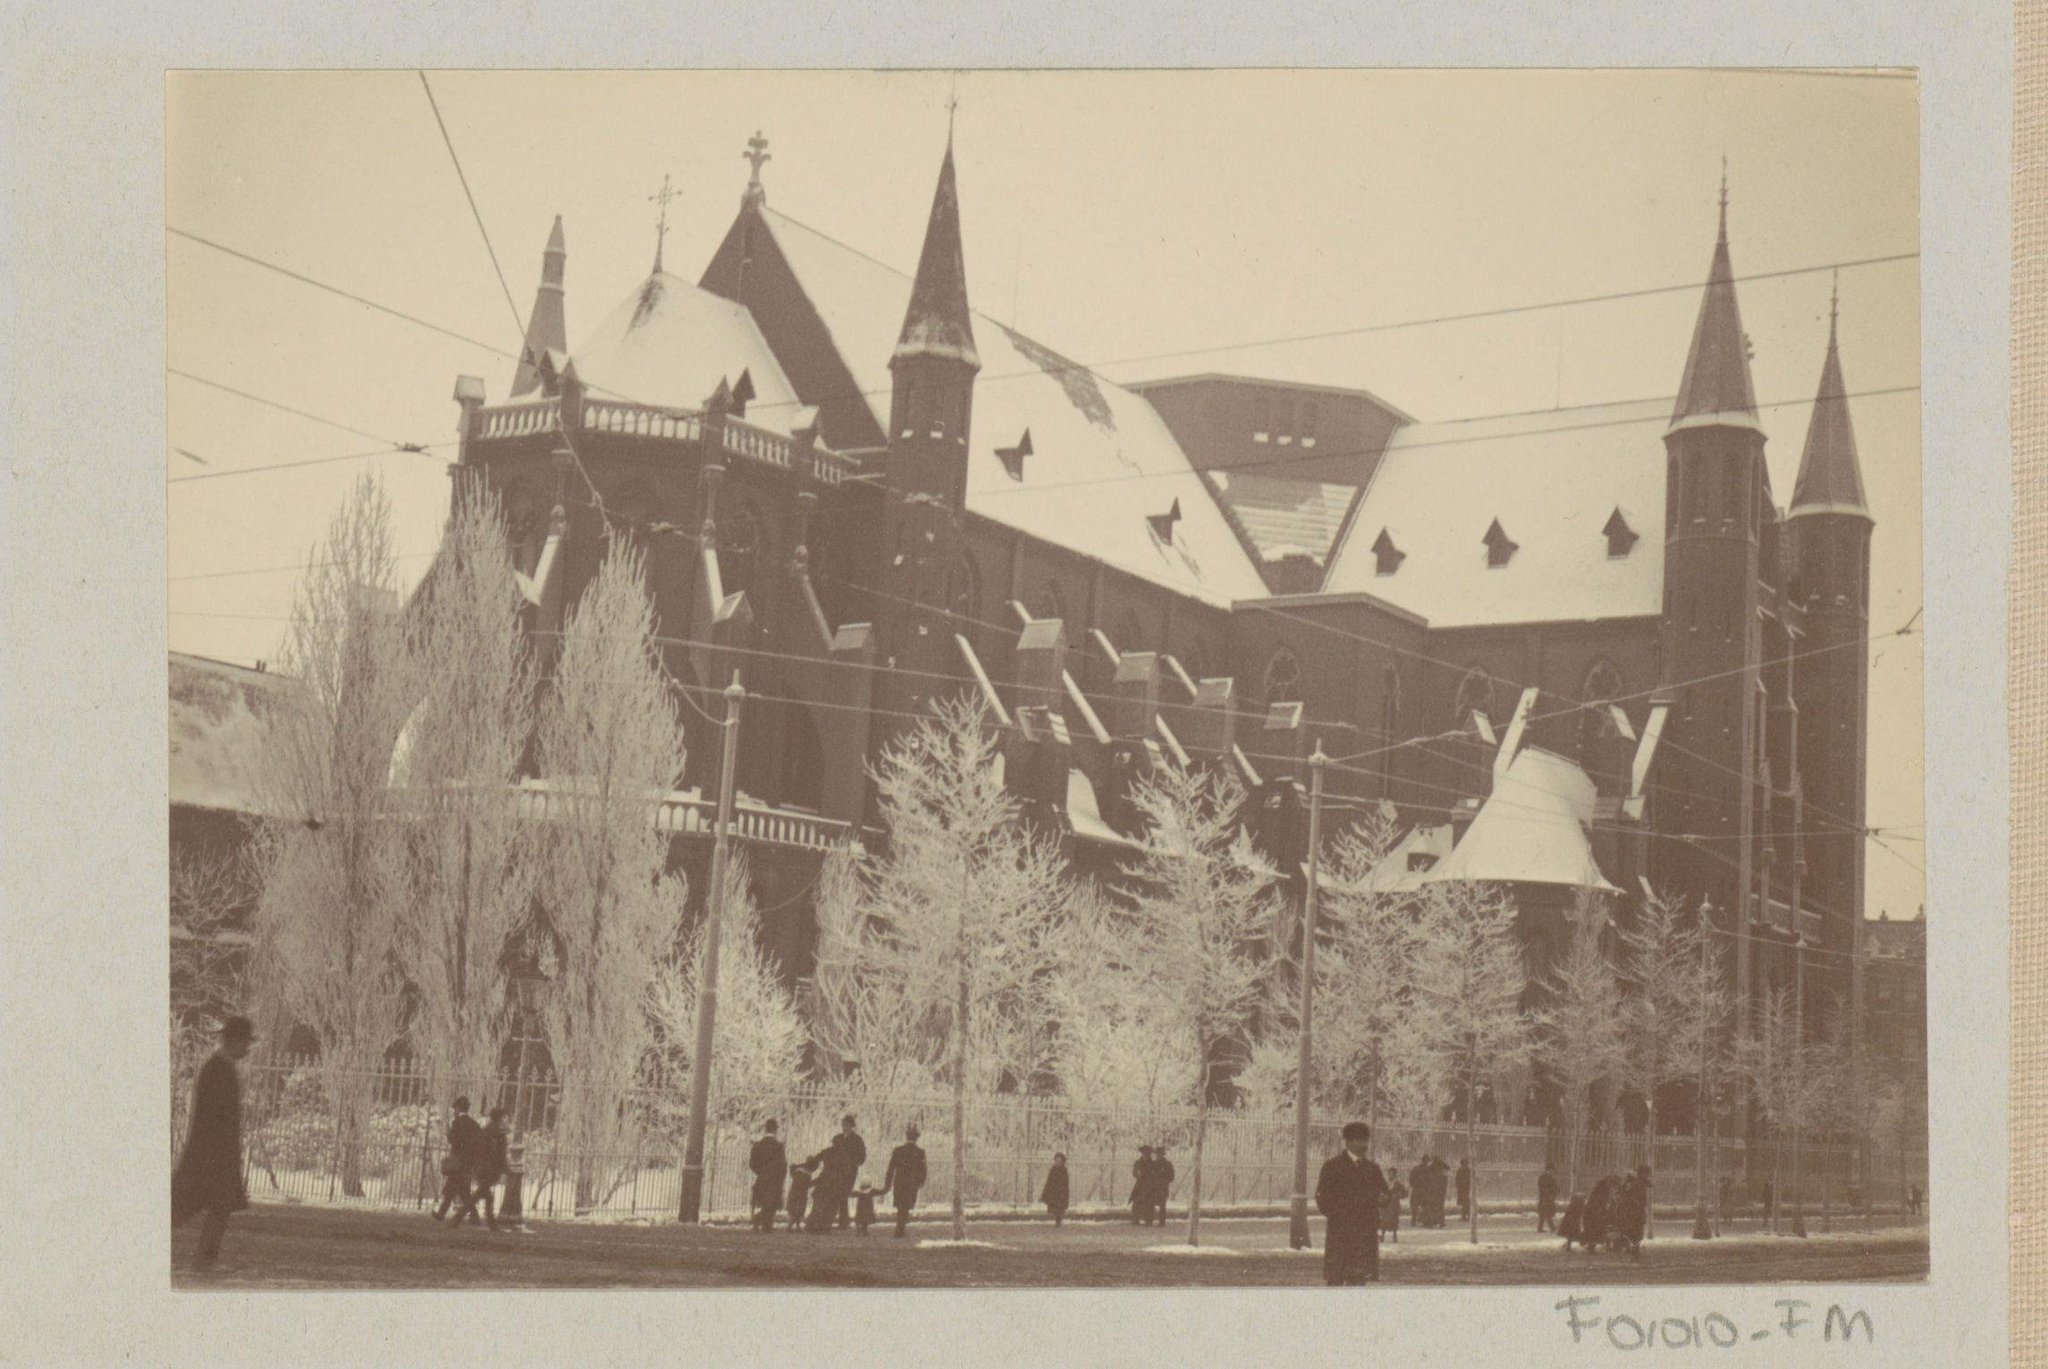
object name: photograph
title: Exterieur van de Sint-Willibrorduskerk buiten de Veste te Amsterdam in de winter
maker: Anonymous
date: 1900-1910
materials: photographic support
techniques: daylight paper print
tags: church (exterior), snow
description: Onderdeel van Familiealbum met onder meer foto's van Wijnhandel Kraaij & Co. Bordeaux-Amsterdam.